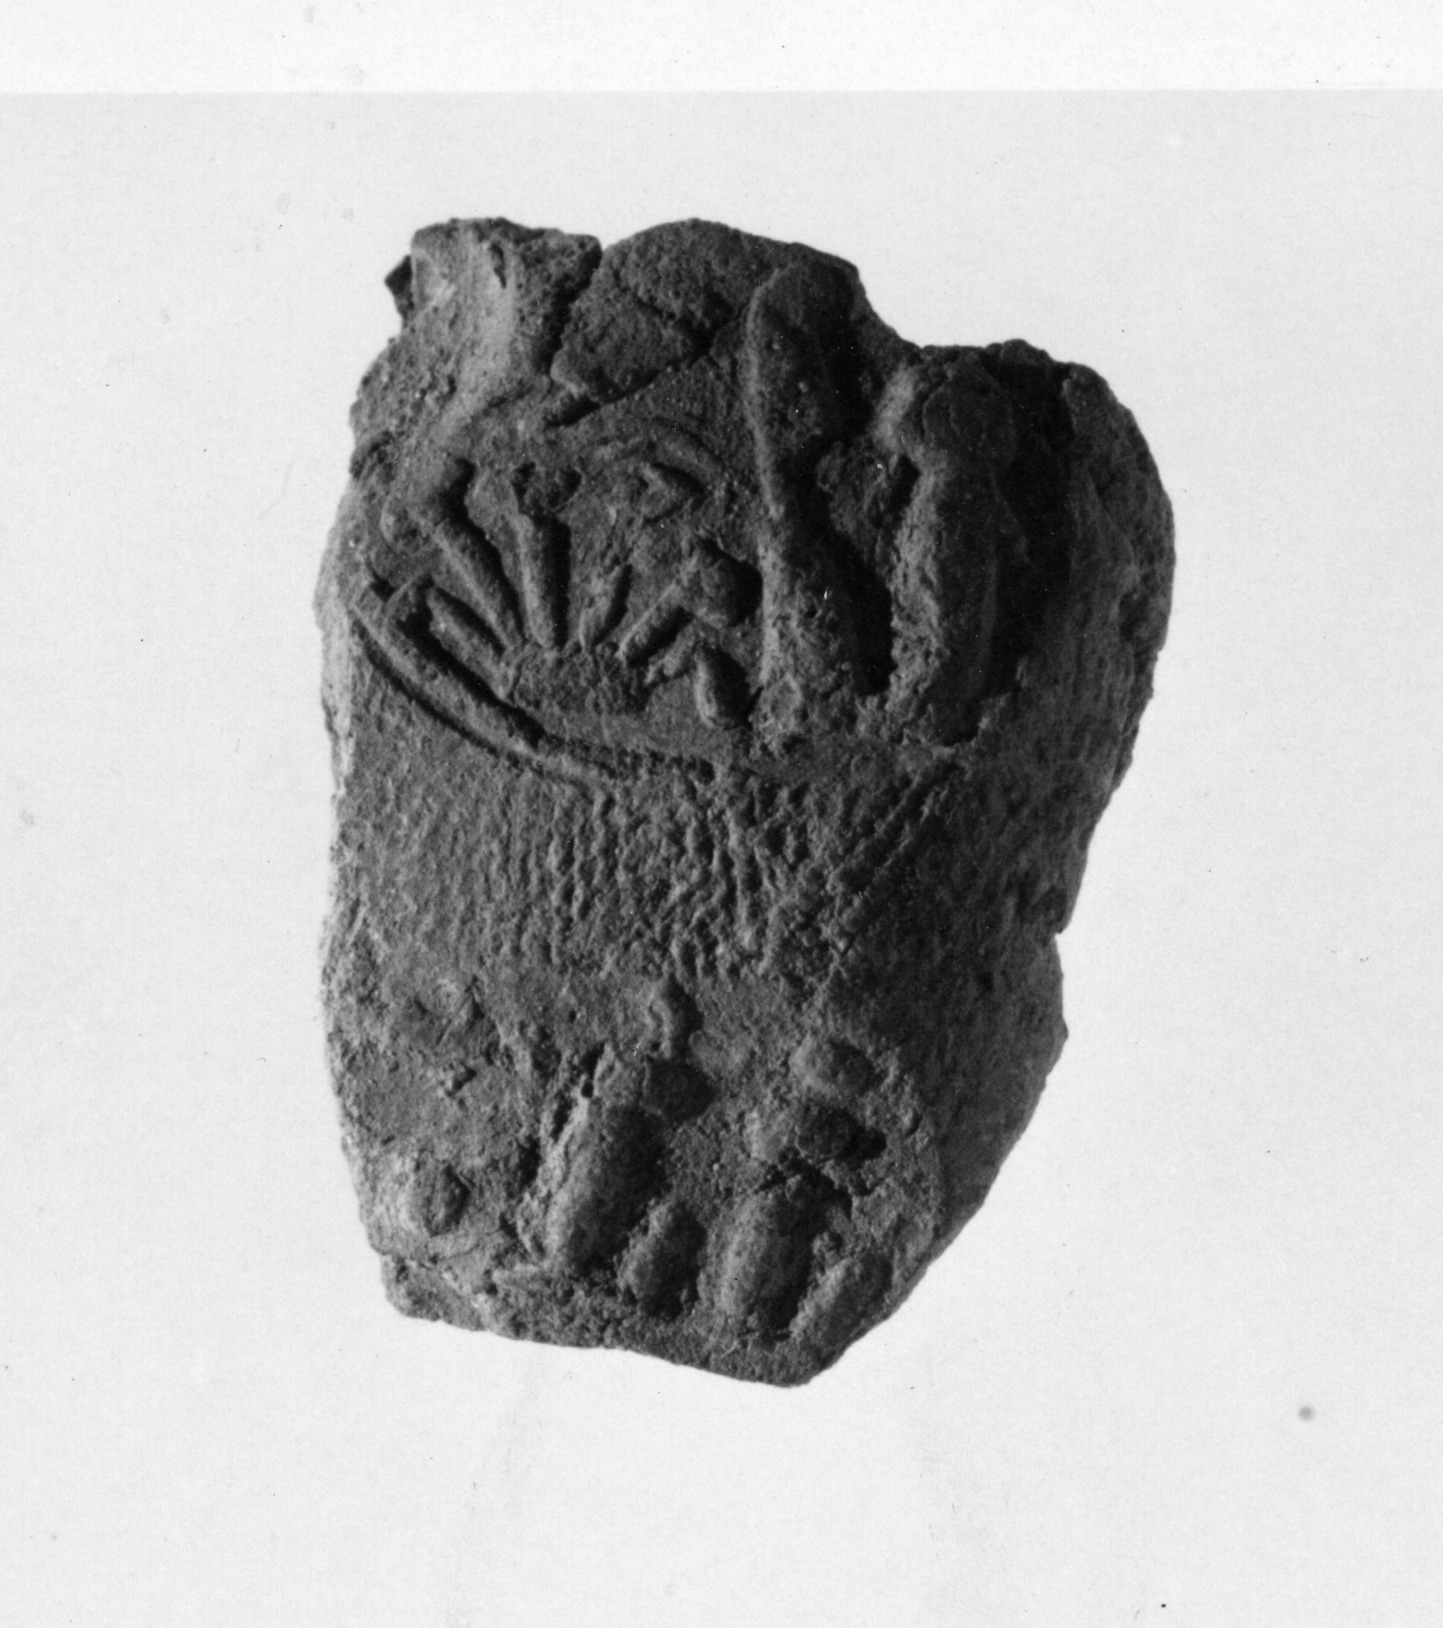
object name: sealing, nebmaatre, amenhotep iii,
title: Document Sealing With Multiple Seal Impressions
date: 1390-1352 BCE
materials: mud